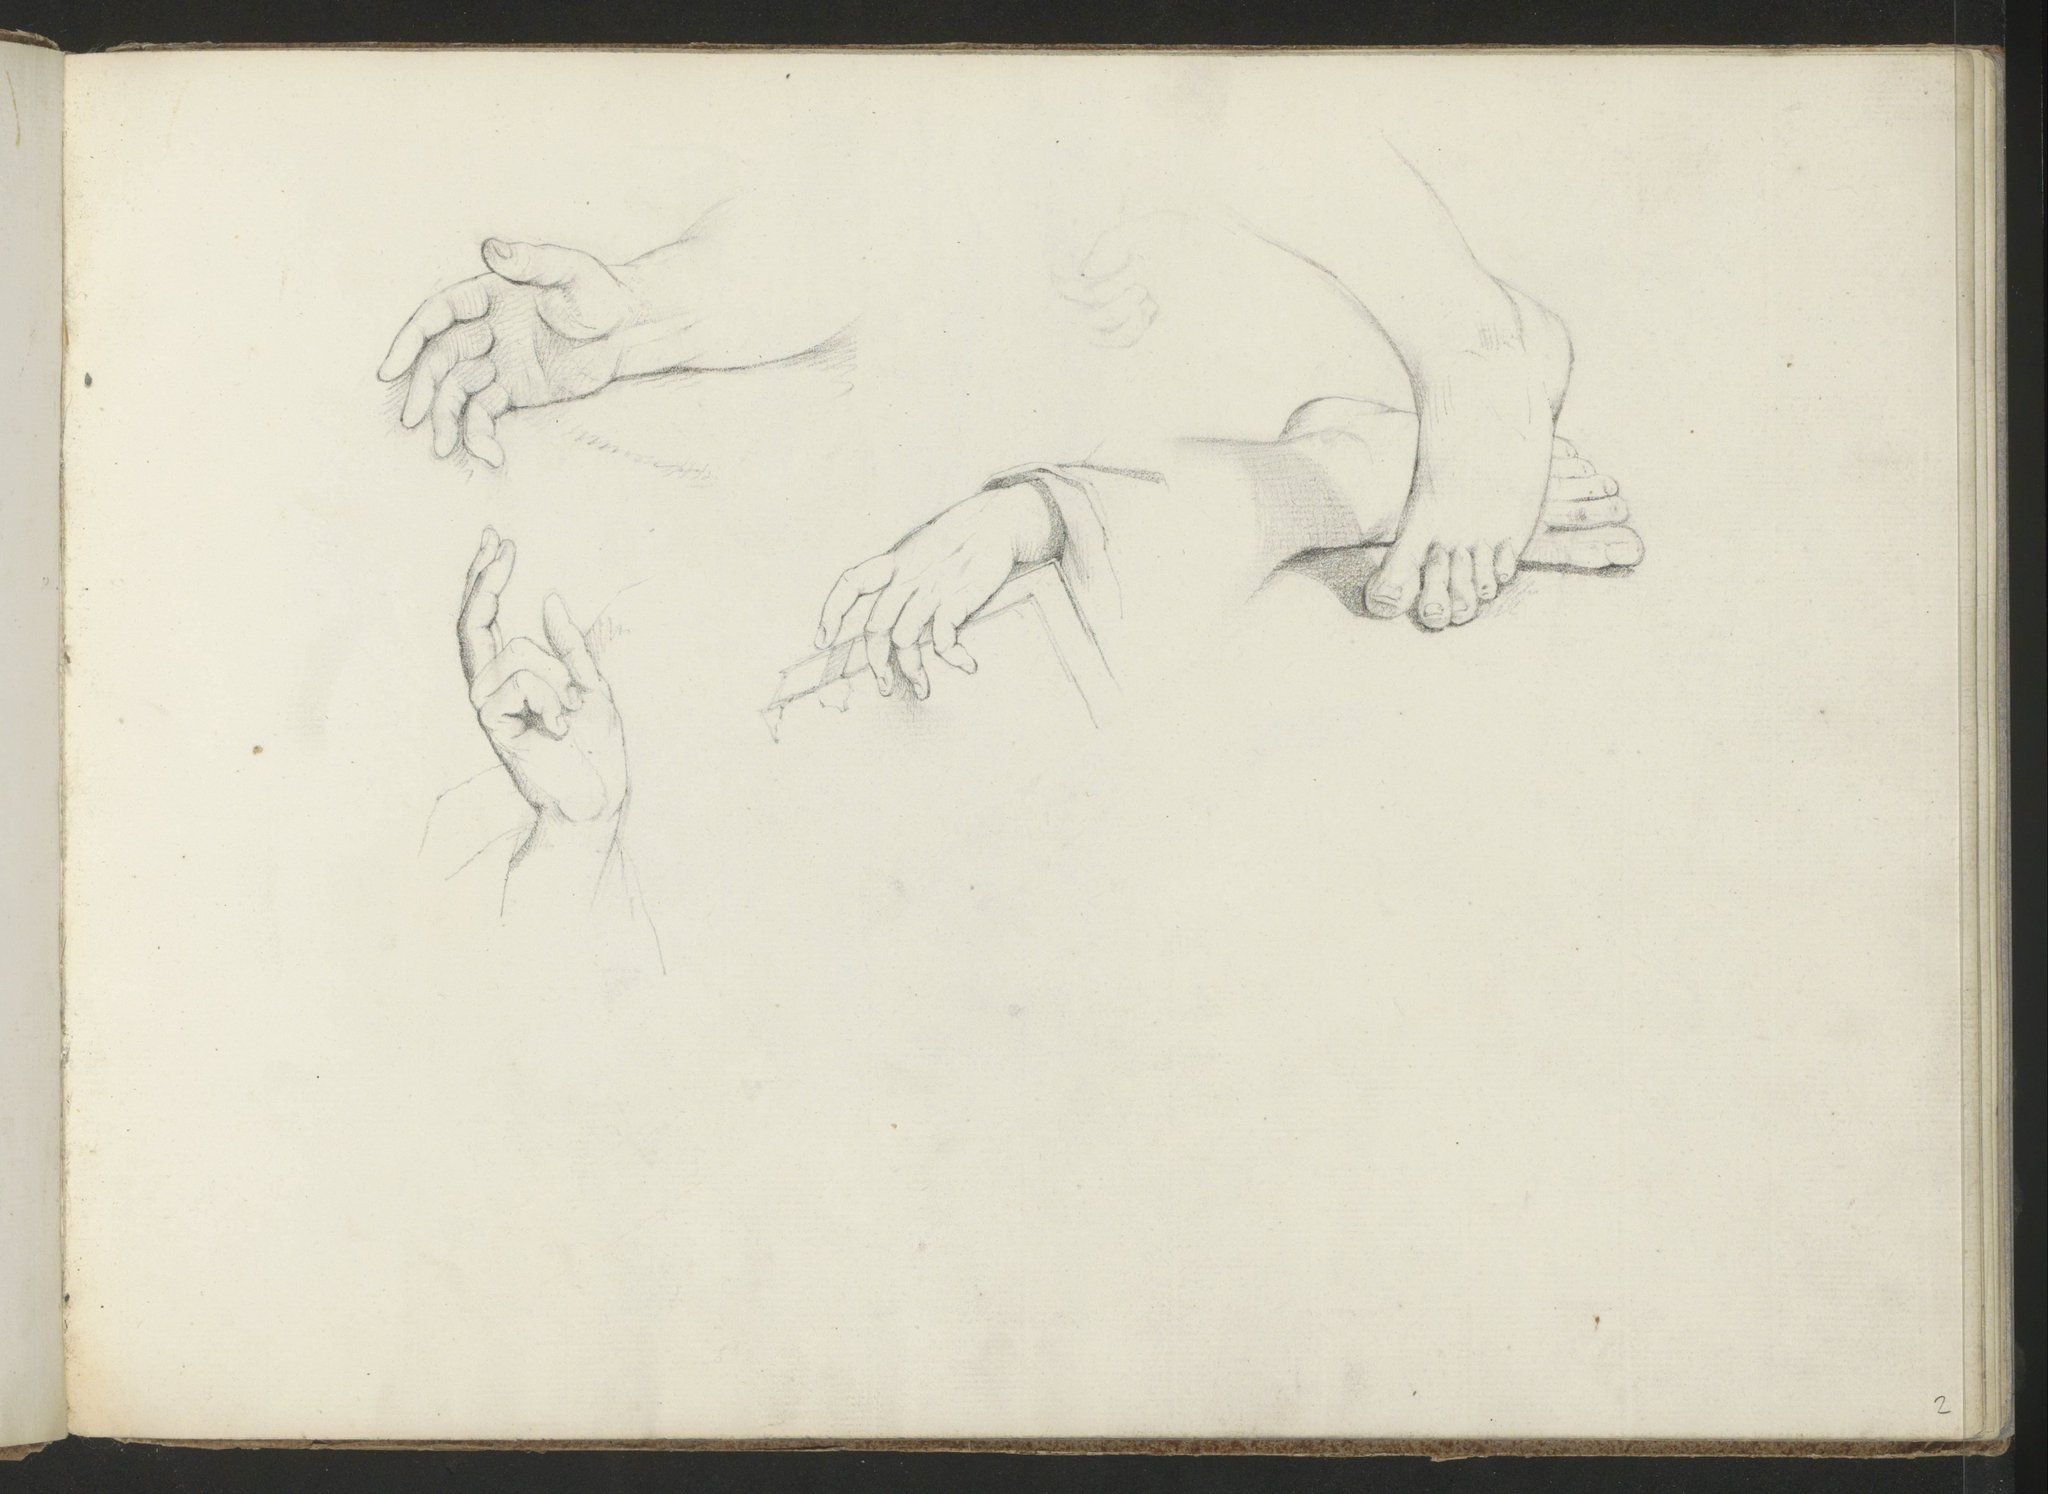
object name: sketchbook leaf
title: Handen en voeten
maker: s. altmann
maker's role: painter, print maker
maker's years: 1822-1890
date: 1803-1840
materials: paper, pencil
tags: hand, foot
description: Blad 2 recto uit een schetsboek met 24 bladen.